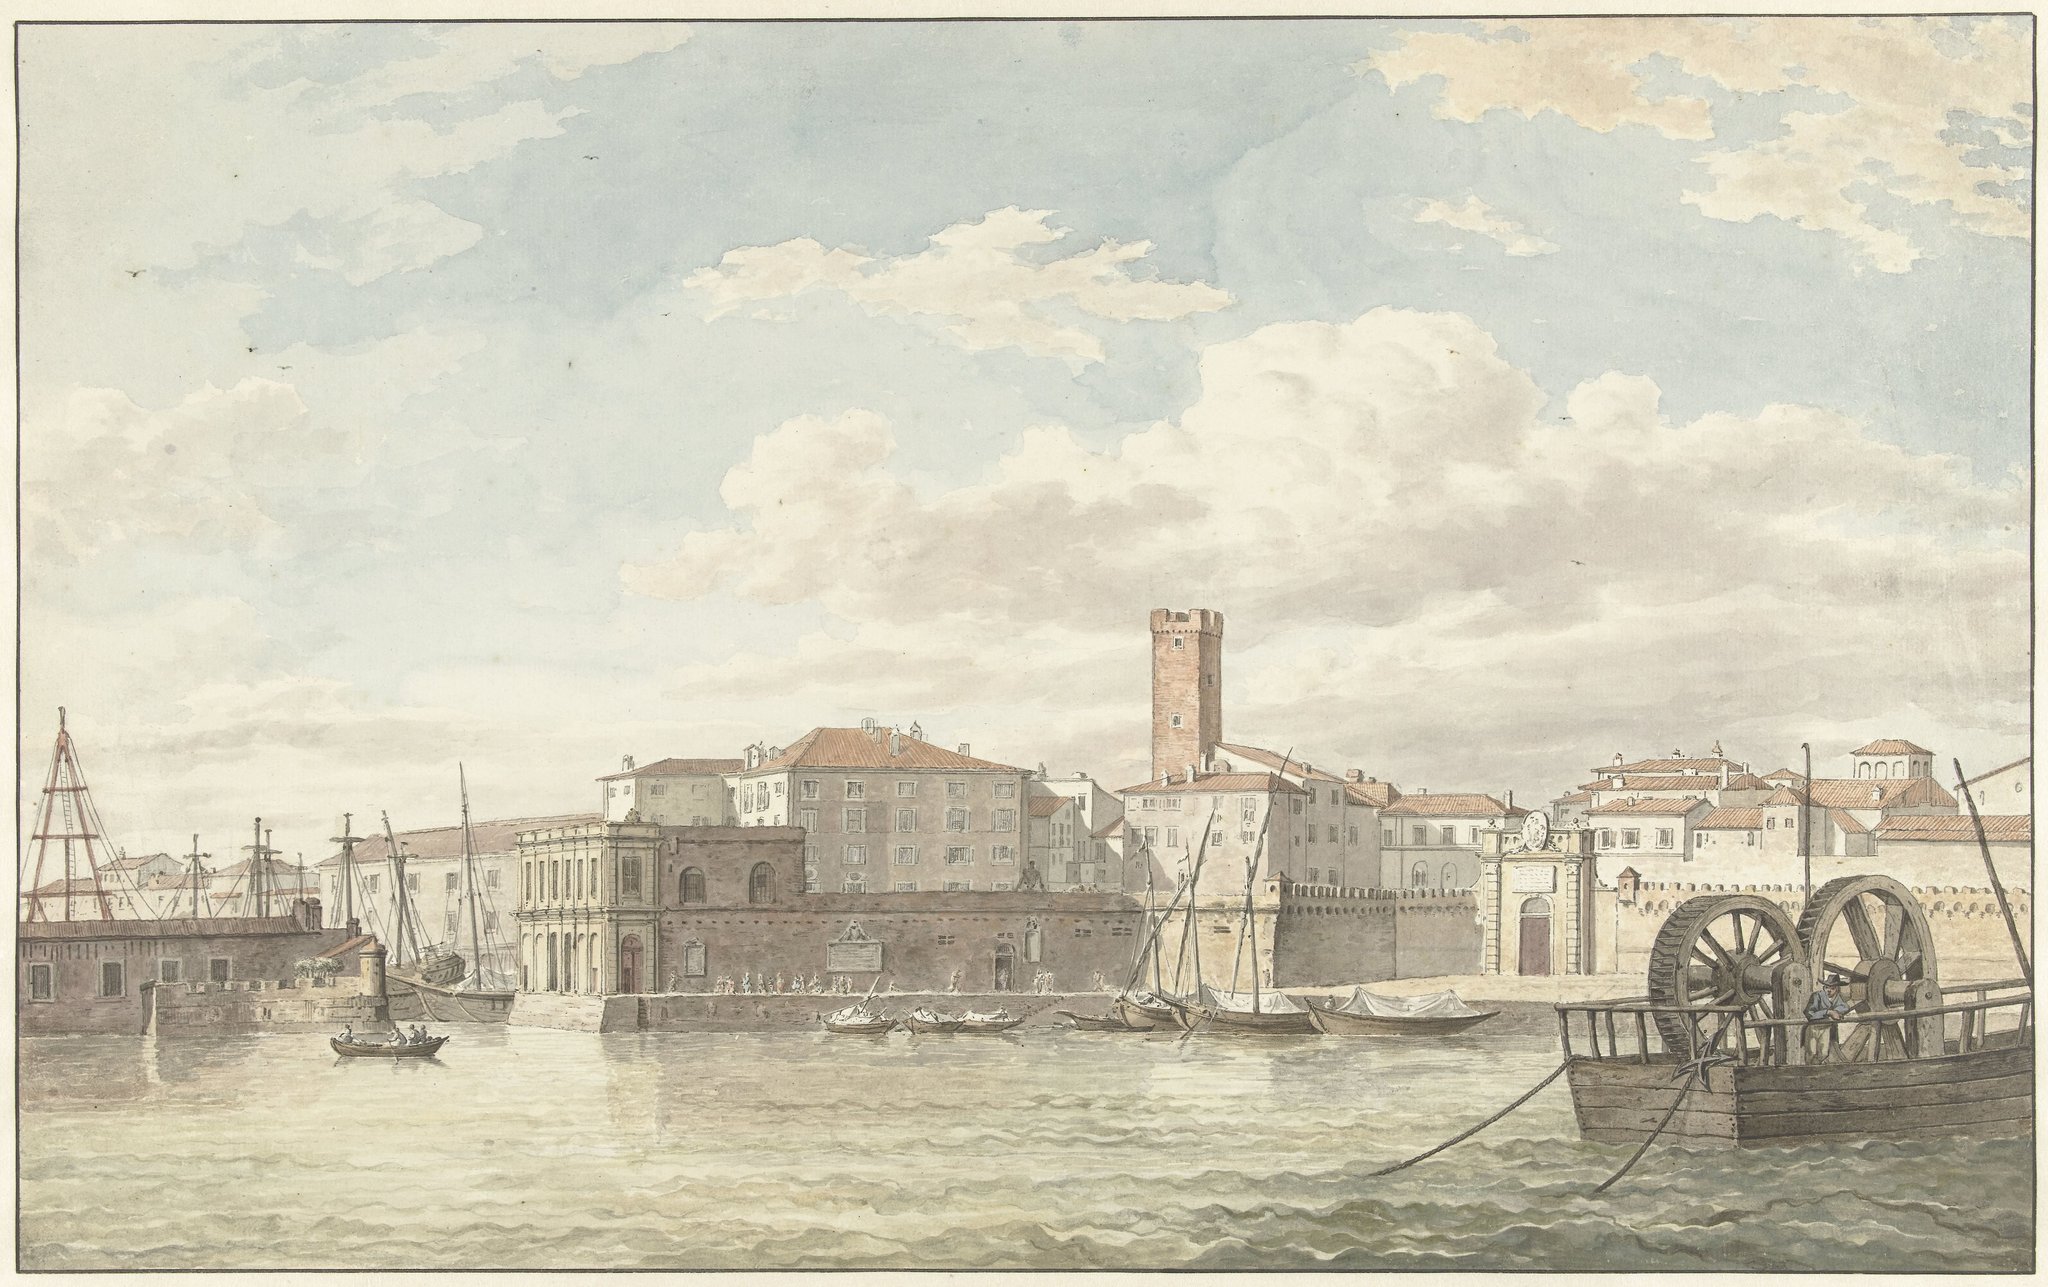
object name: drawing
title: De haven van Civitavecchia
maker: jean grandjean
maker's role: draughtsman, print maker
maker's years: 1752-1781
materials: chalk, ink, paper, watercolor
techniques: brush, pen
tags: harbour, city-view, and landscape with man-made constructions